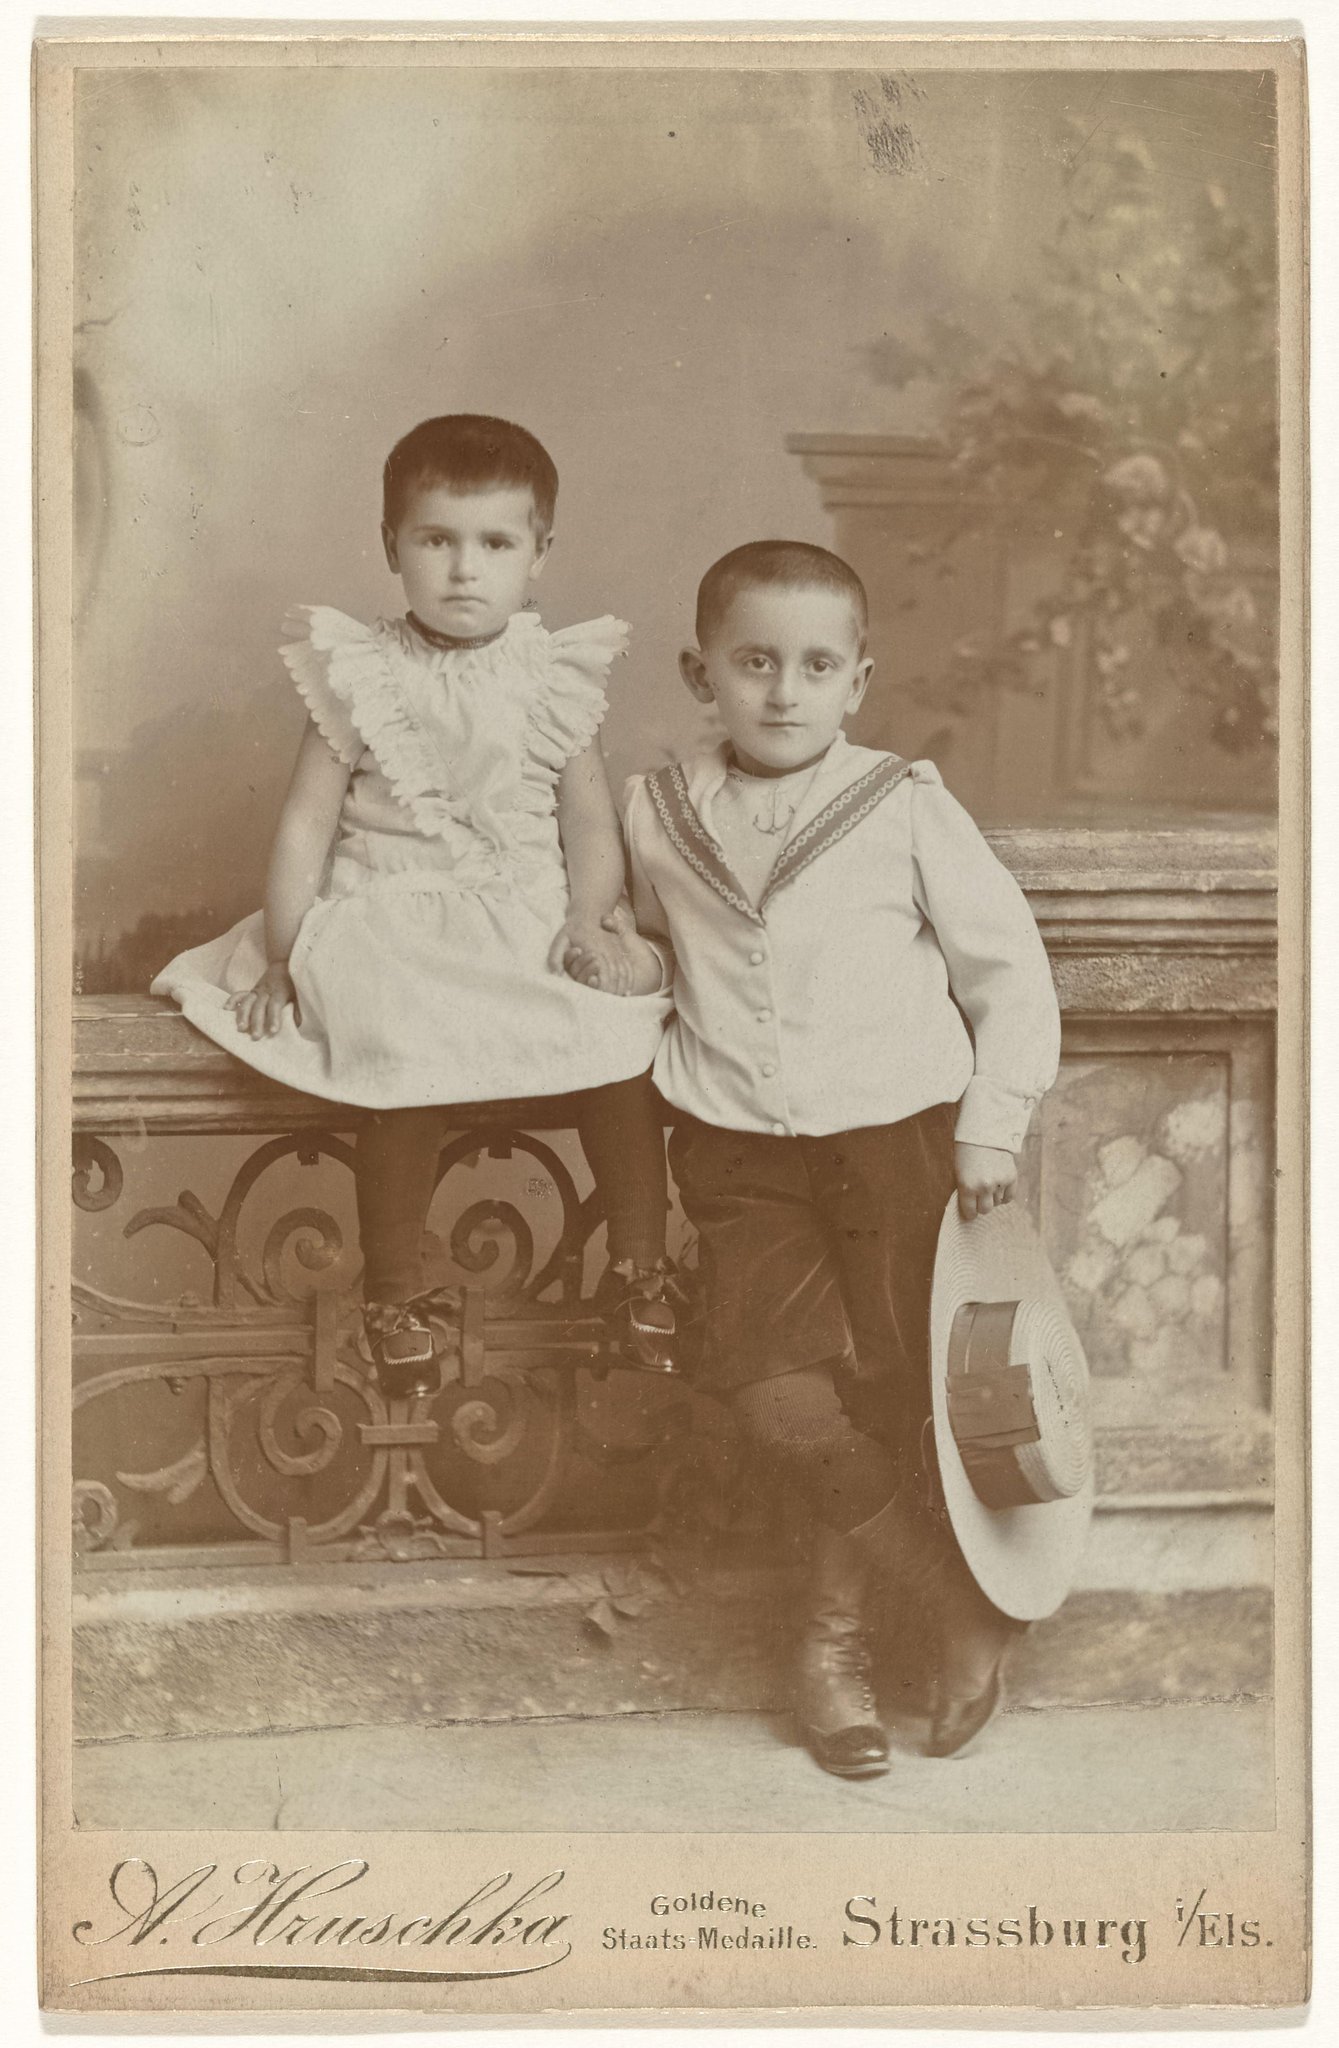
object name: photograph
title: Photographs from the Estate of Isabel Wachenheimer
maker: anton hruschka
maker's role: fotograaf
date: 1891-1896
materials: photographic support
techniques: gelatin silver print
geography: straatsburg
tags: eugen wachenheimer, ensembles of pieces of clothing (matelot) (+ boys' clothes)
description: The German Eugen Wachenheimer had a brilliant career at the Deutsche Bank and served as a naval officer in the First World War. In 1922 he married Else Moos. The Anti-Jewish laws instituted by the Nazi regime forced them to flee to the Netherlands in 1937. The photograph at the lower right is the last one taken of Eugen. He stands with his back to the camera behind his daughter. Eugen and Else were gassed at Auschwitz-Birkenau in 1944.